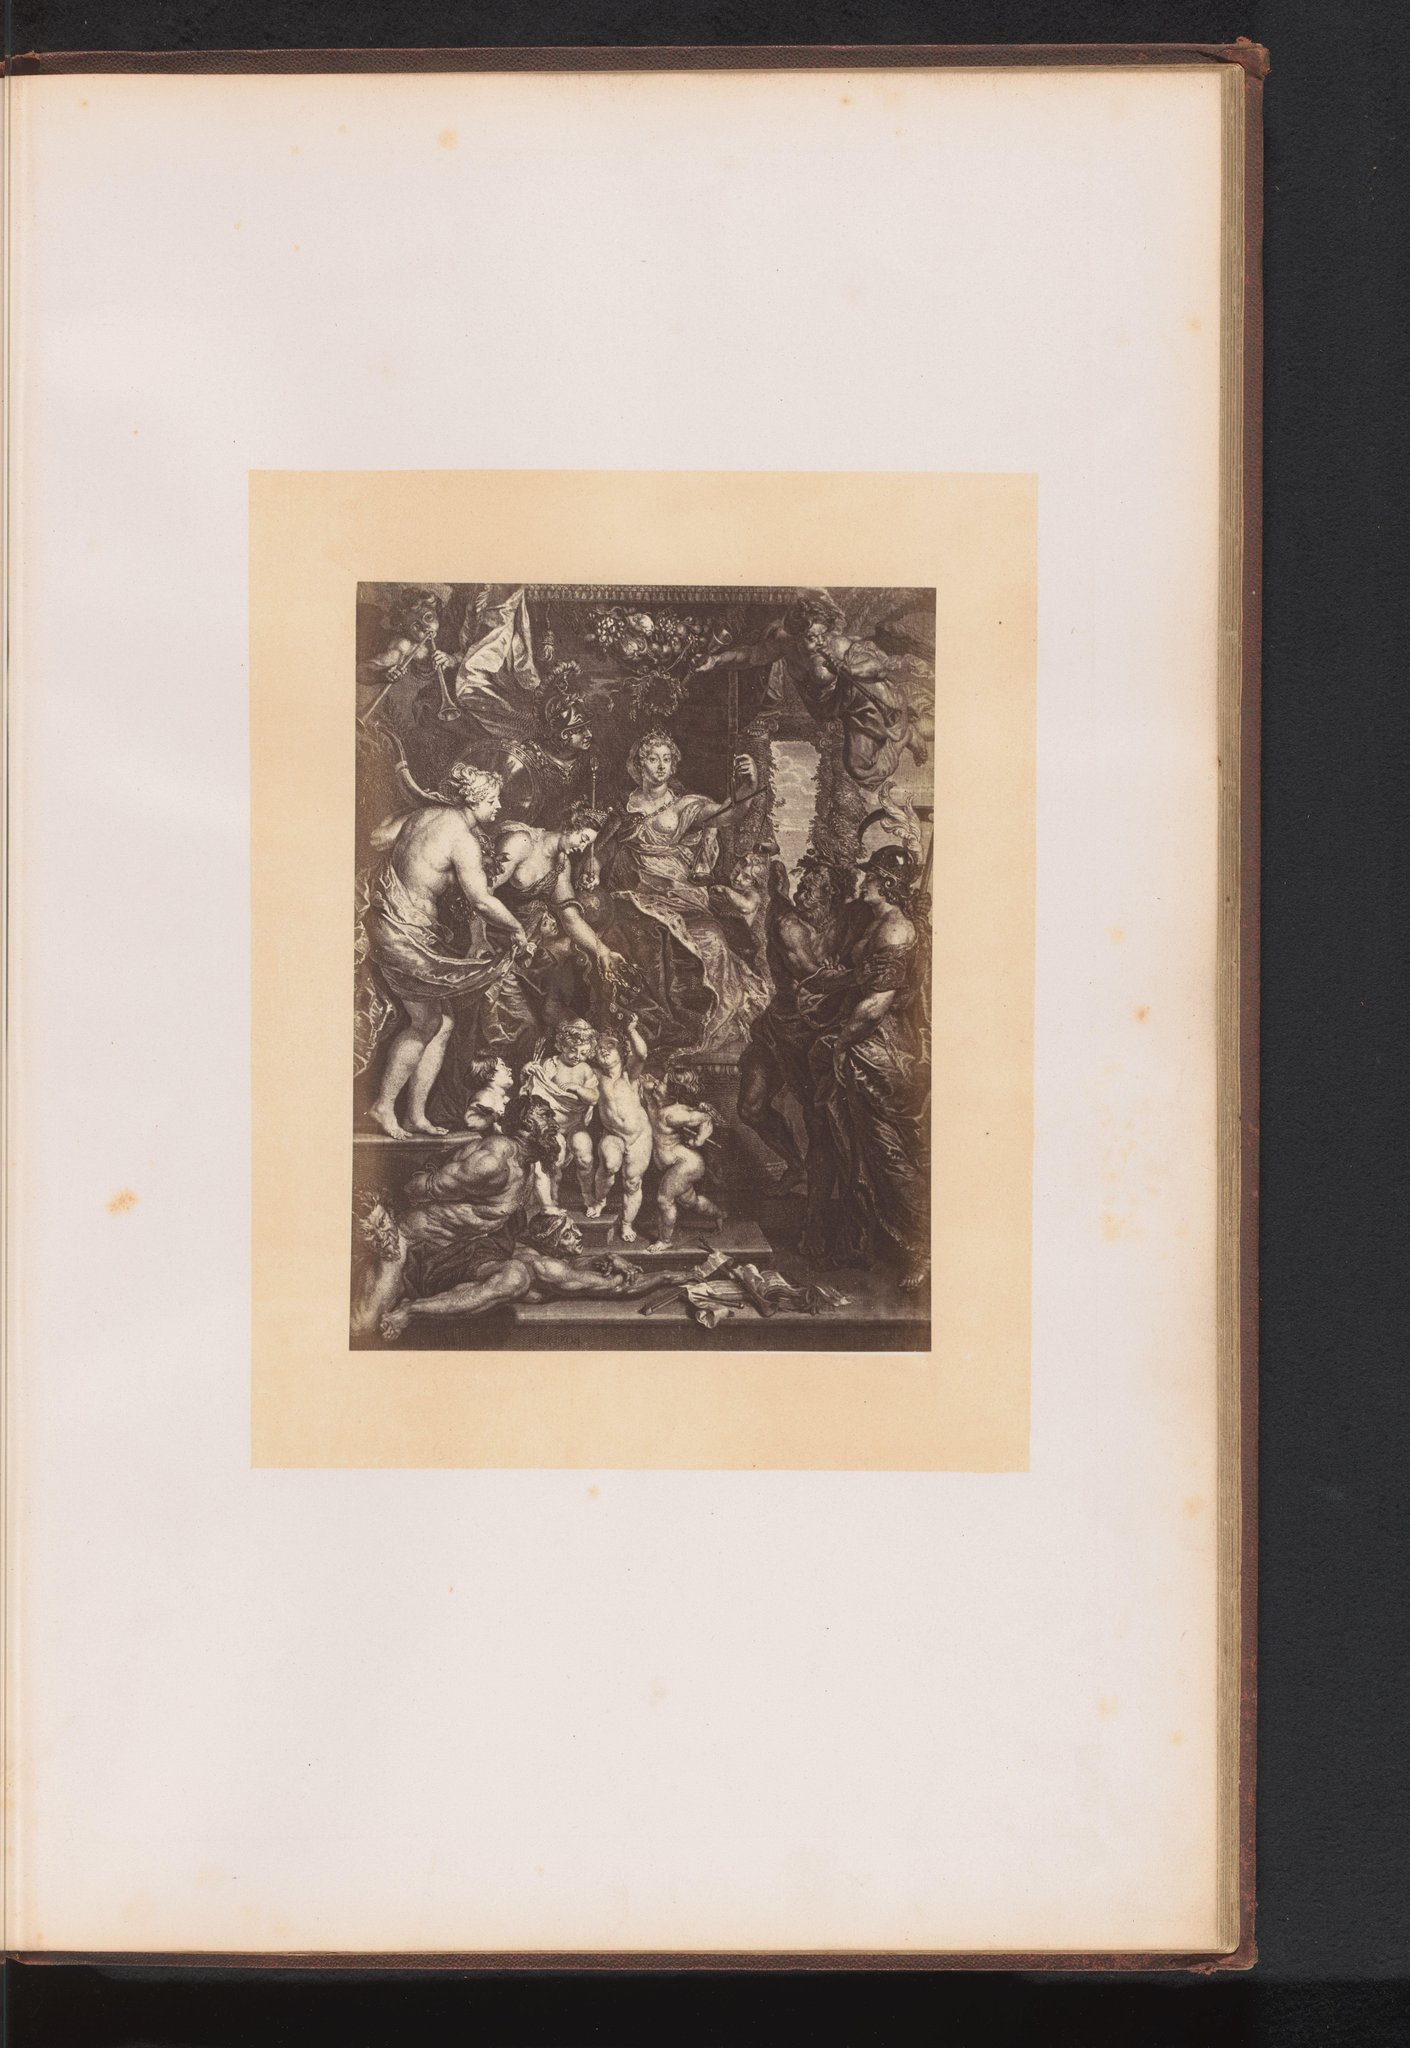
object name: page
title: Fotoreproductie van een gravure van De gelukzaligheid van het regentschap van Maria de'Medici door Jean-Marc Nattier, naar het schilderij door Peter Paul Rubens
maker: peter paul rubens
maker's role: draughtsman, painter, print maker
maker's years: 1577-1640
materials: photographic support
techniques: albumen print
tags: print maker, maria de' medici, ruler, sovereign - bb - female ruler